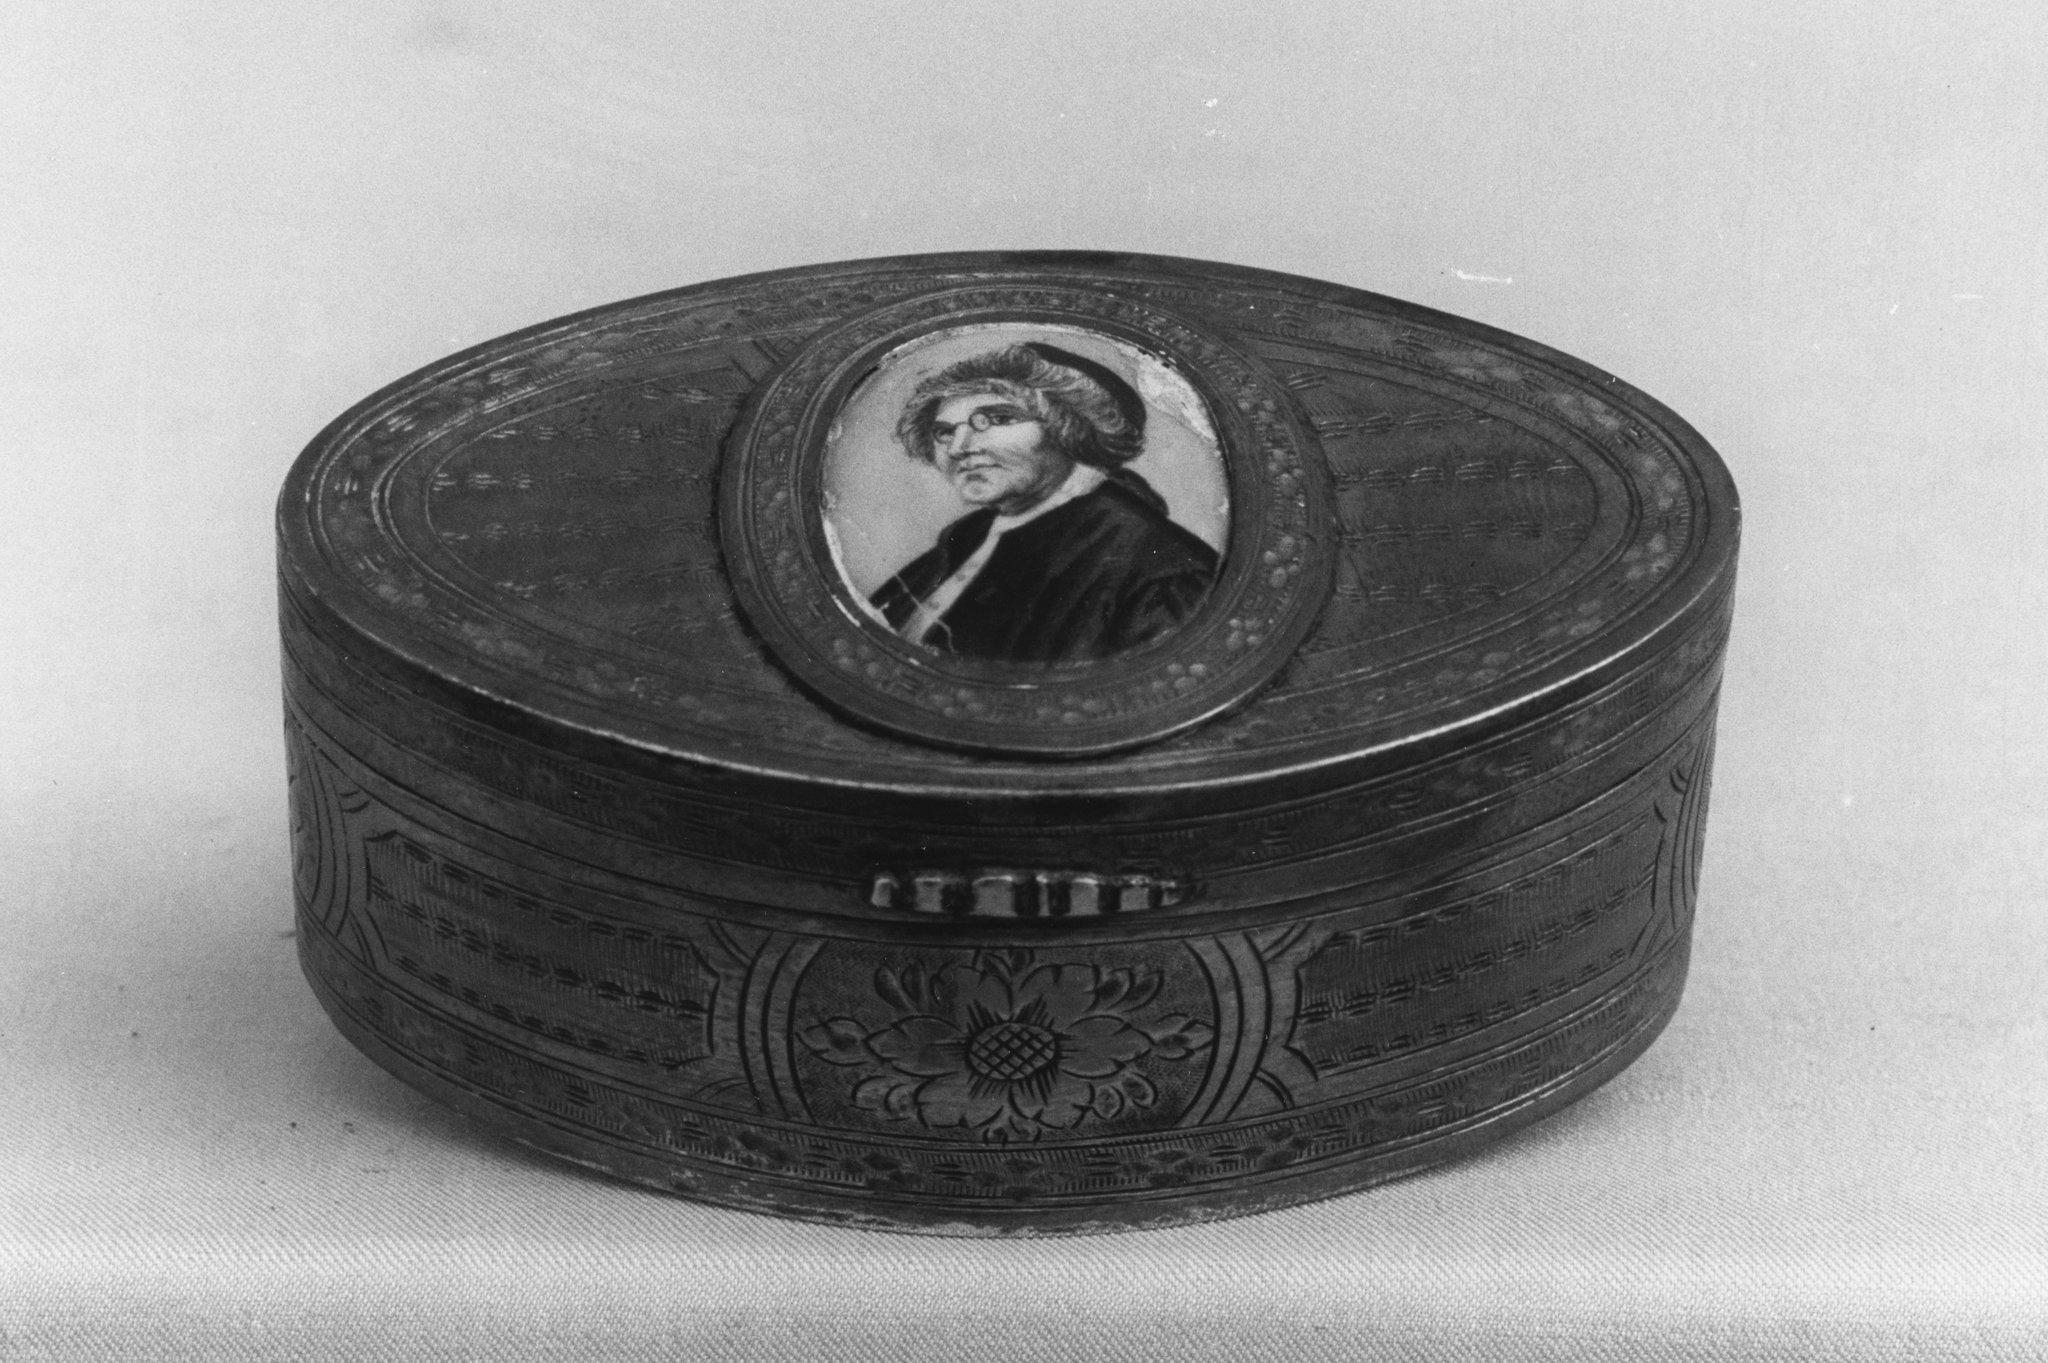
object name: box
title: Box with Medallion Top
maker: charles nicolas cochin ii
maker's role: maker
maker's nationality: french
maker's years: 1715-1790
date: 1775-1883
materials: pewter, silver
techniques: enamel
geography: france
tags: men,portraits